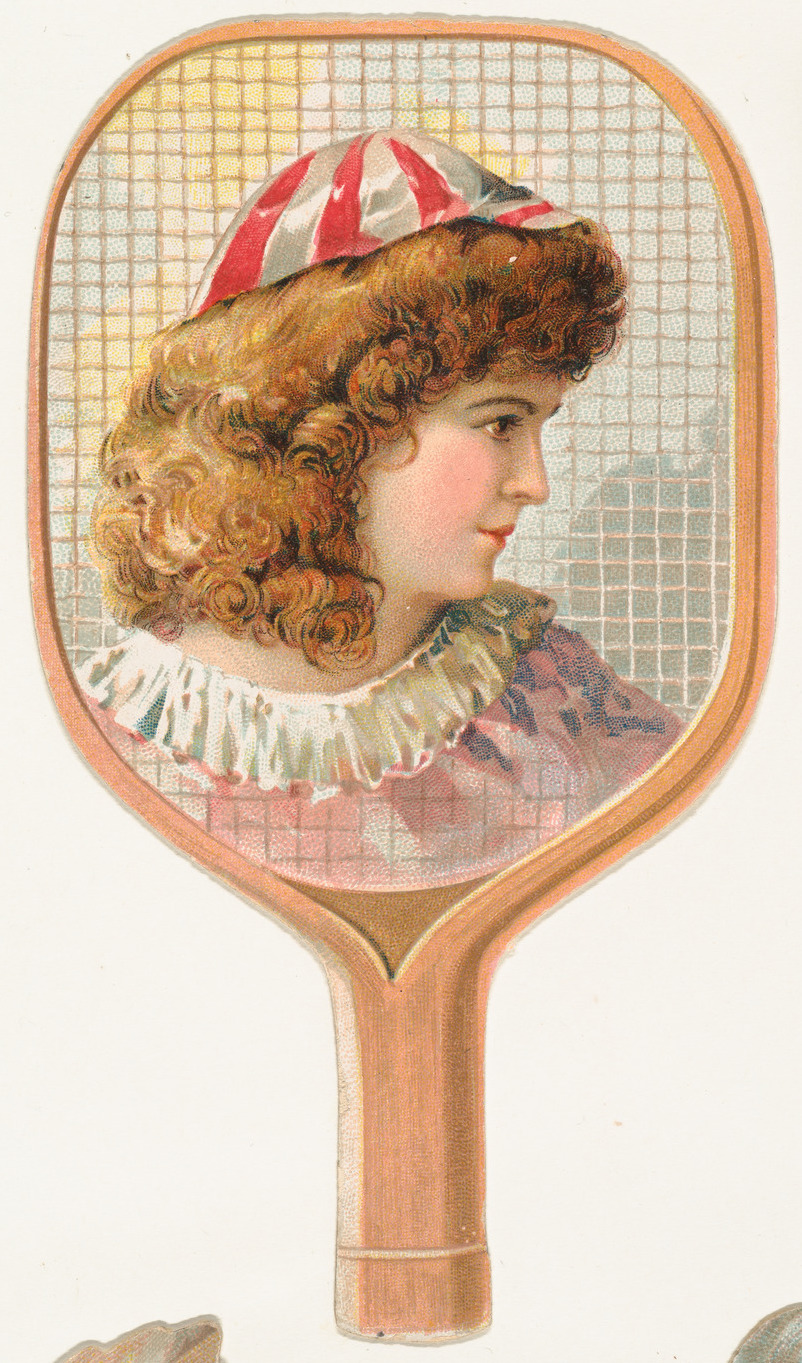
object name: print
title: Tennis Racket, from the Novelties series (N122) issued by Gail & Ax Tobacco to promote Navy Long Cut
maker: gail & ax tobacco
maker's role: publisher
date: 1889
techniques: color lithograph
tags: profiles,women,tennis